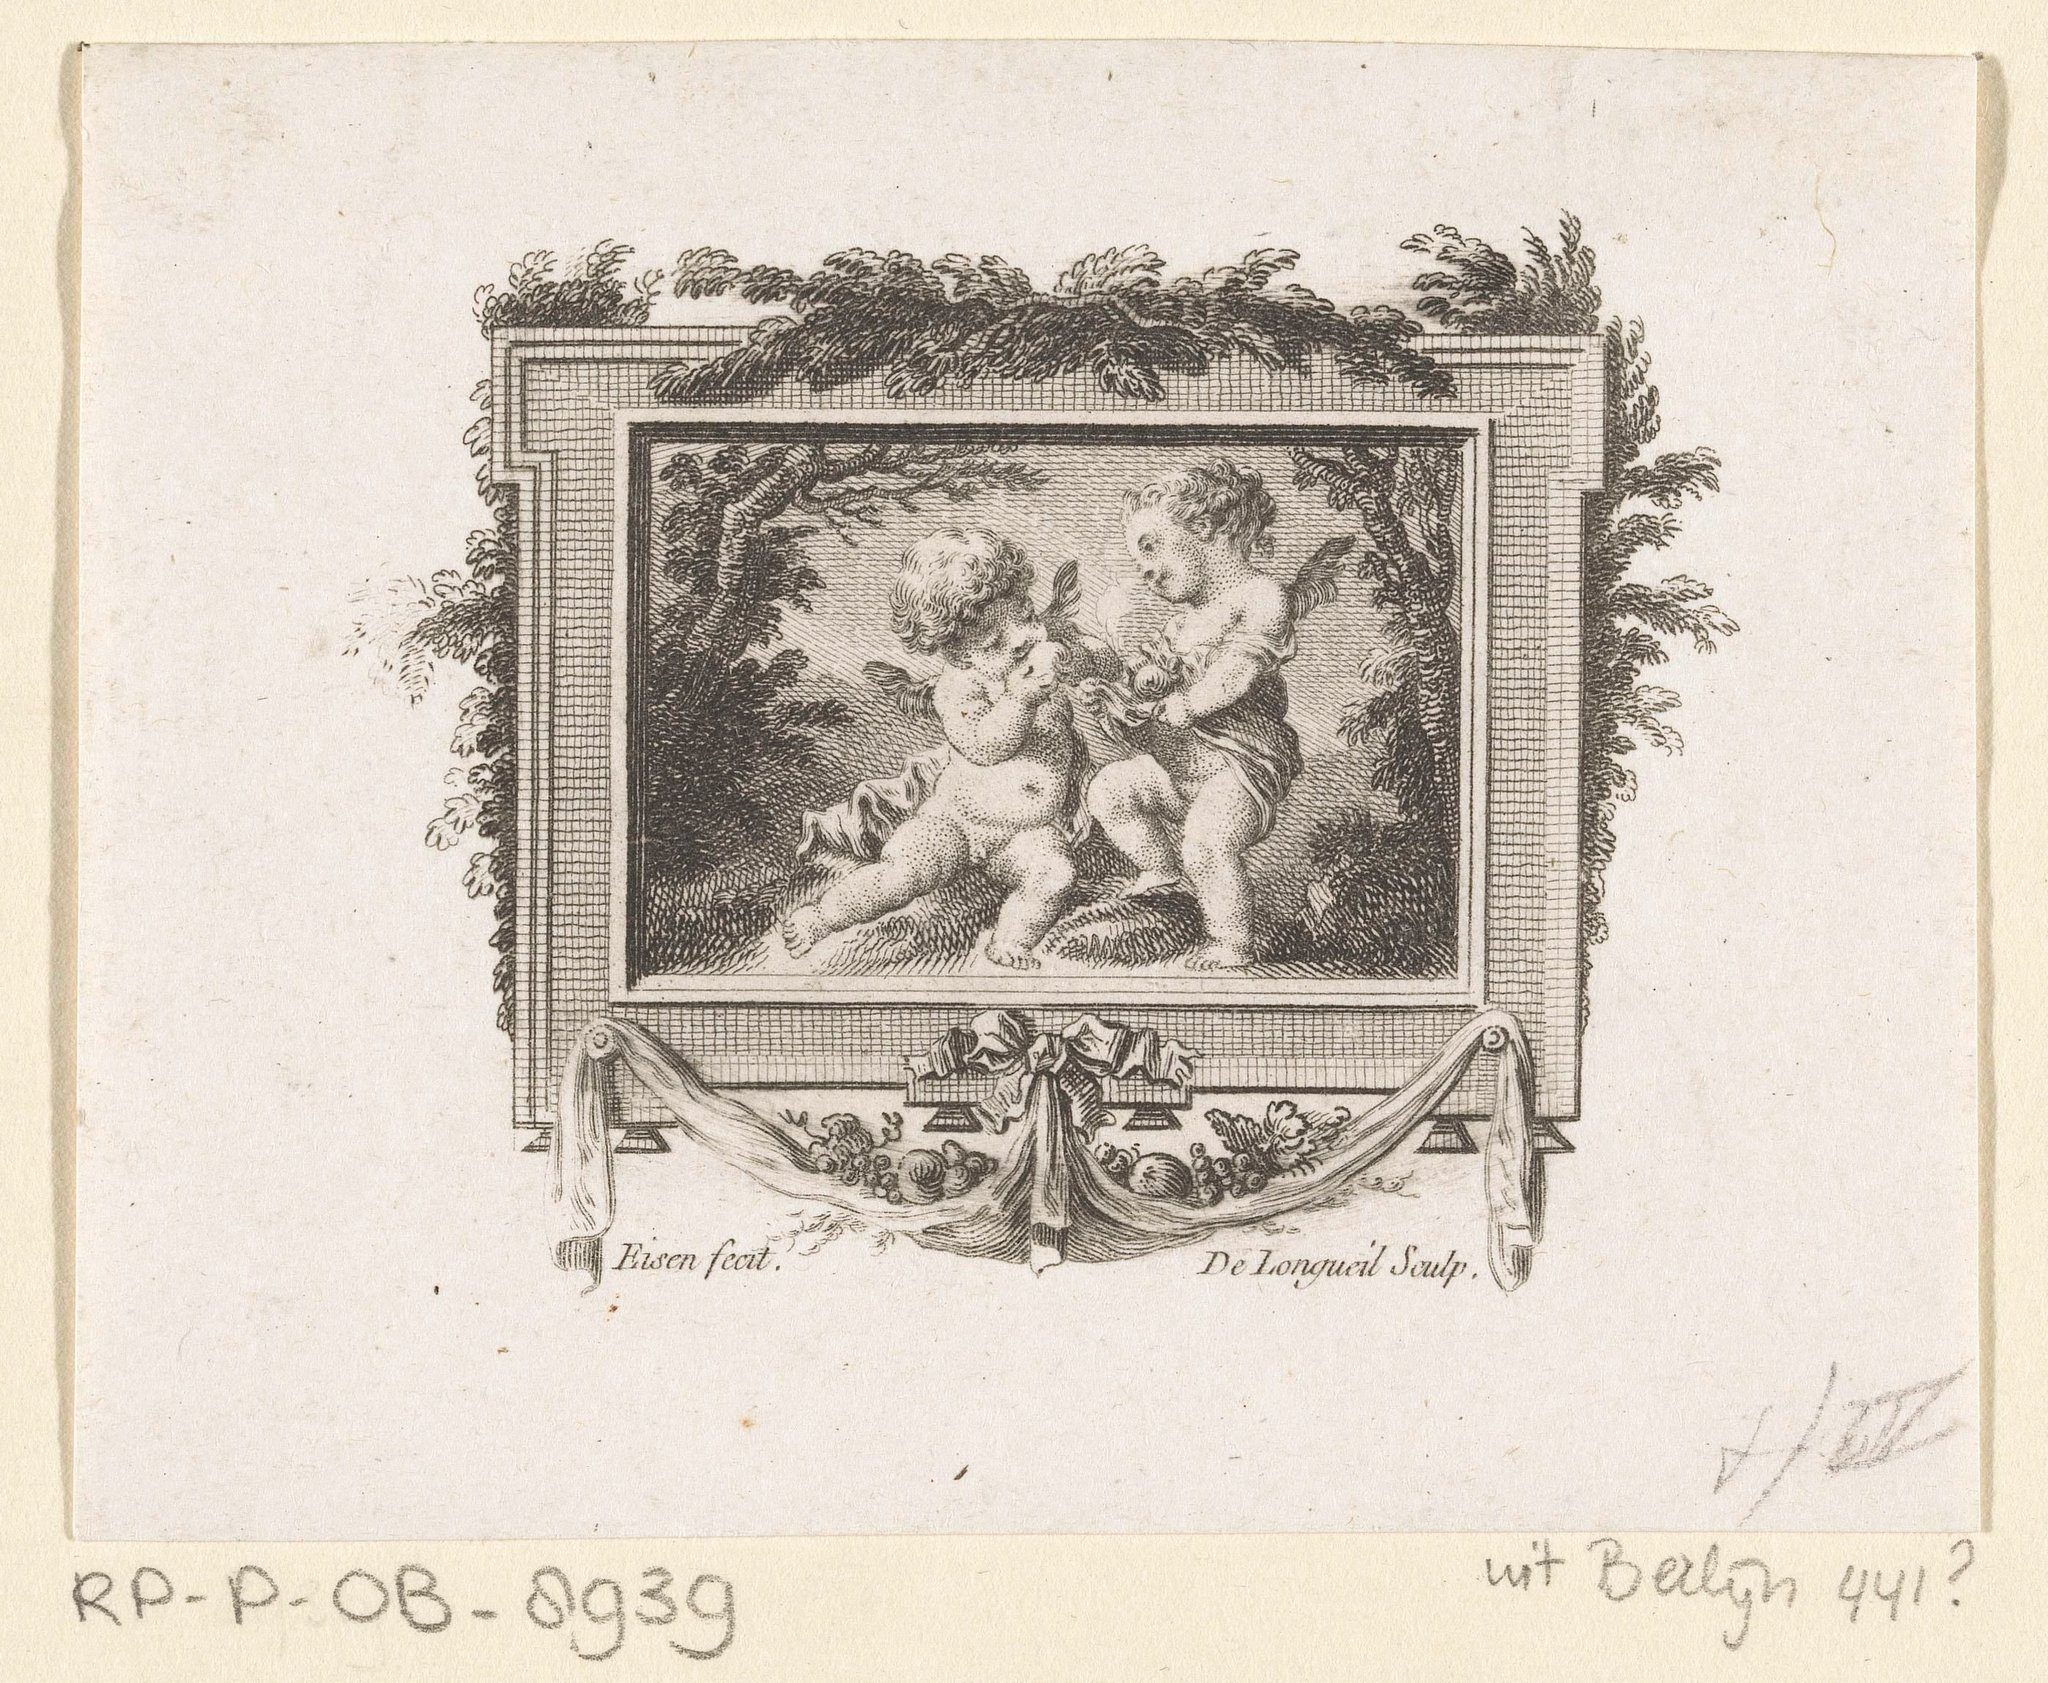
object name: print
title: Vignet met twee putti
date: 1763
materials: paper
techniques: etching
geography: france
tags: vignette, cupids: 'amores', 'amoretti', 'putti', eating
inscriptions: collector's mark: Lugt 240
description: Vignet met twee fruit etende putti in een rechthoekige omlijsting.